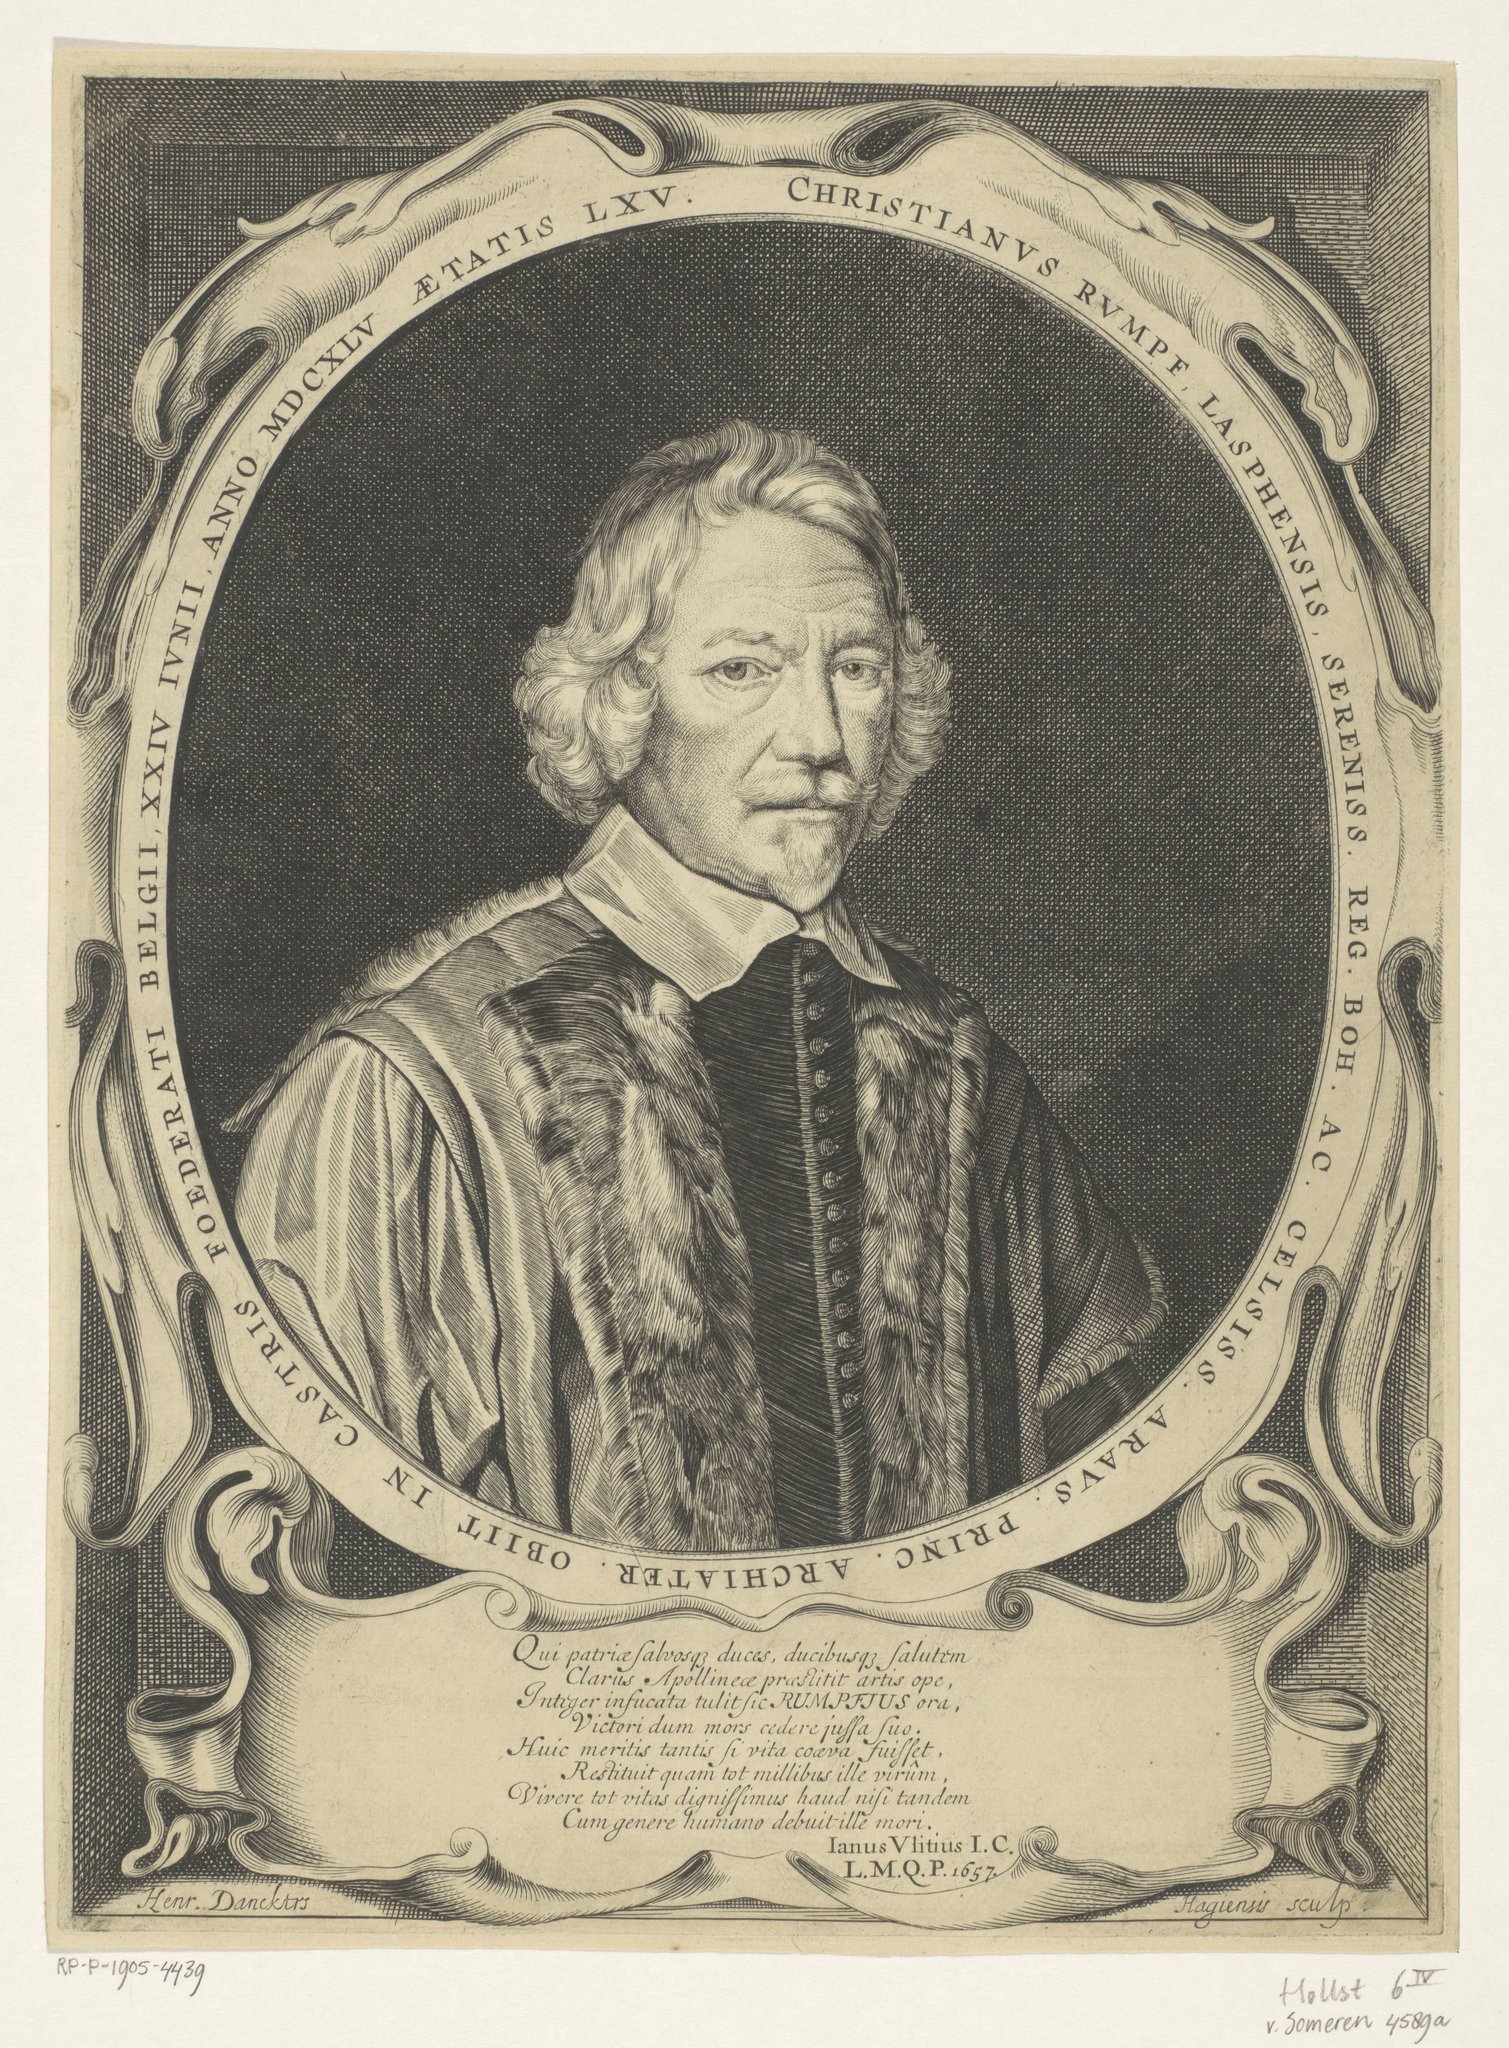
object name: print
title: Portret van Christiaan Rumpf op 65-jarige leeftijd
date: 1657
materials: paper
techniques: engraving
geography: the hague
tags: physician, doctor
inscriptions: collector's mark: Lugt 2228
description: Portret van Christiaan Rumpf op 65 jarige leeftijd, buste in ovale omlijsting met rolwerk. Onder portret cartouche met Latijns vers in acht regels door Janus Vlitius.